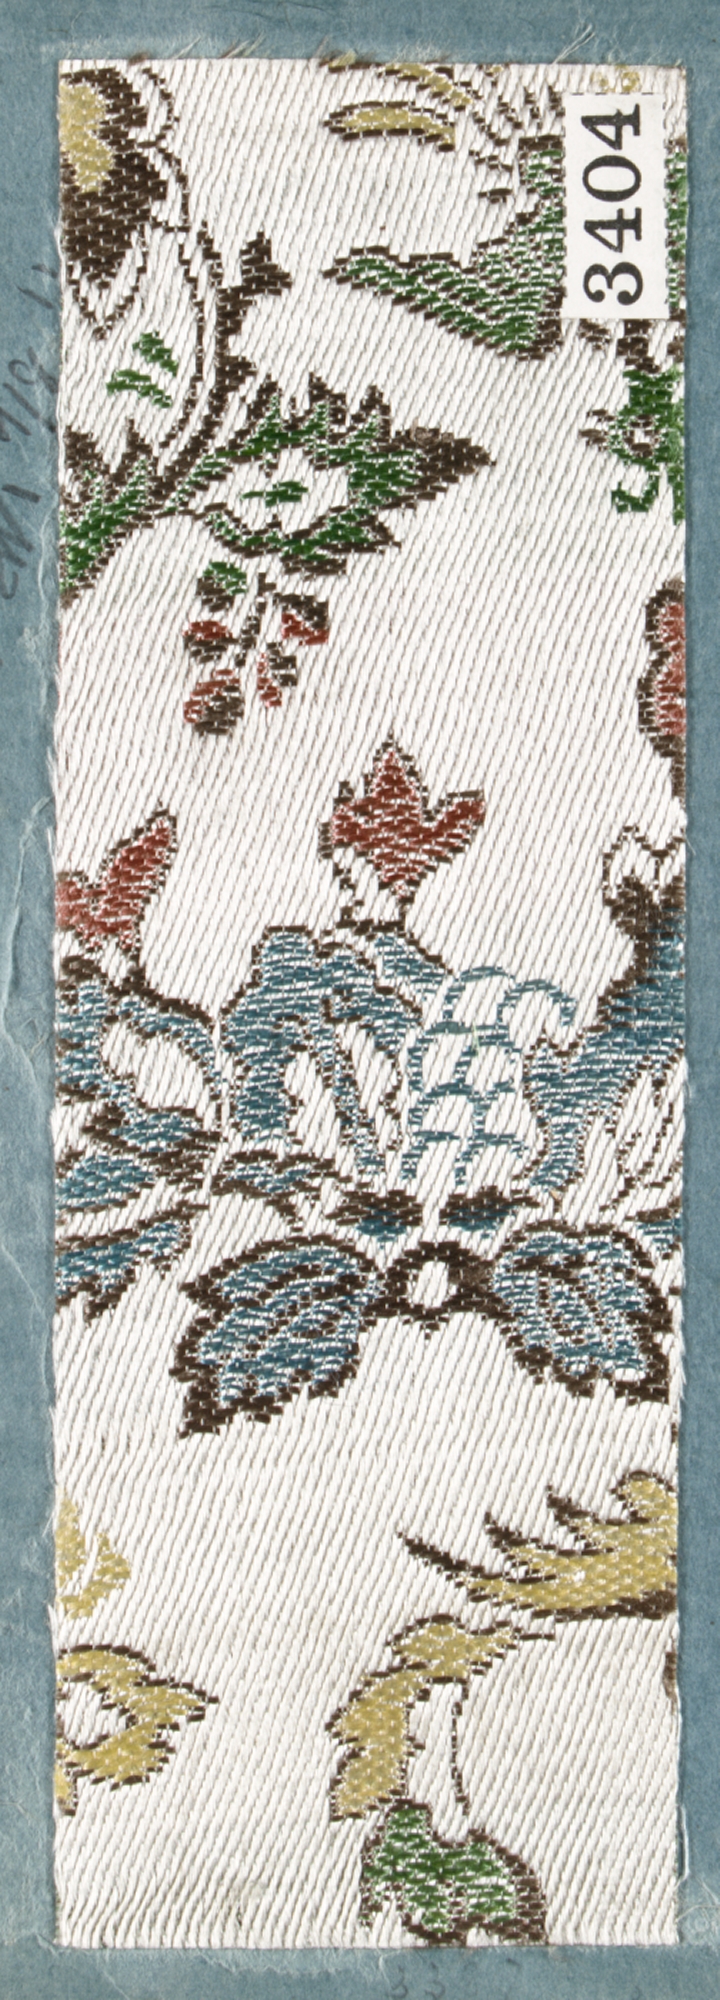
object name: textile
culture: japanese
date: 1801-1900